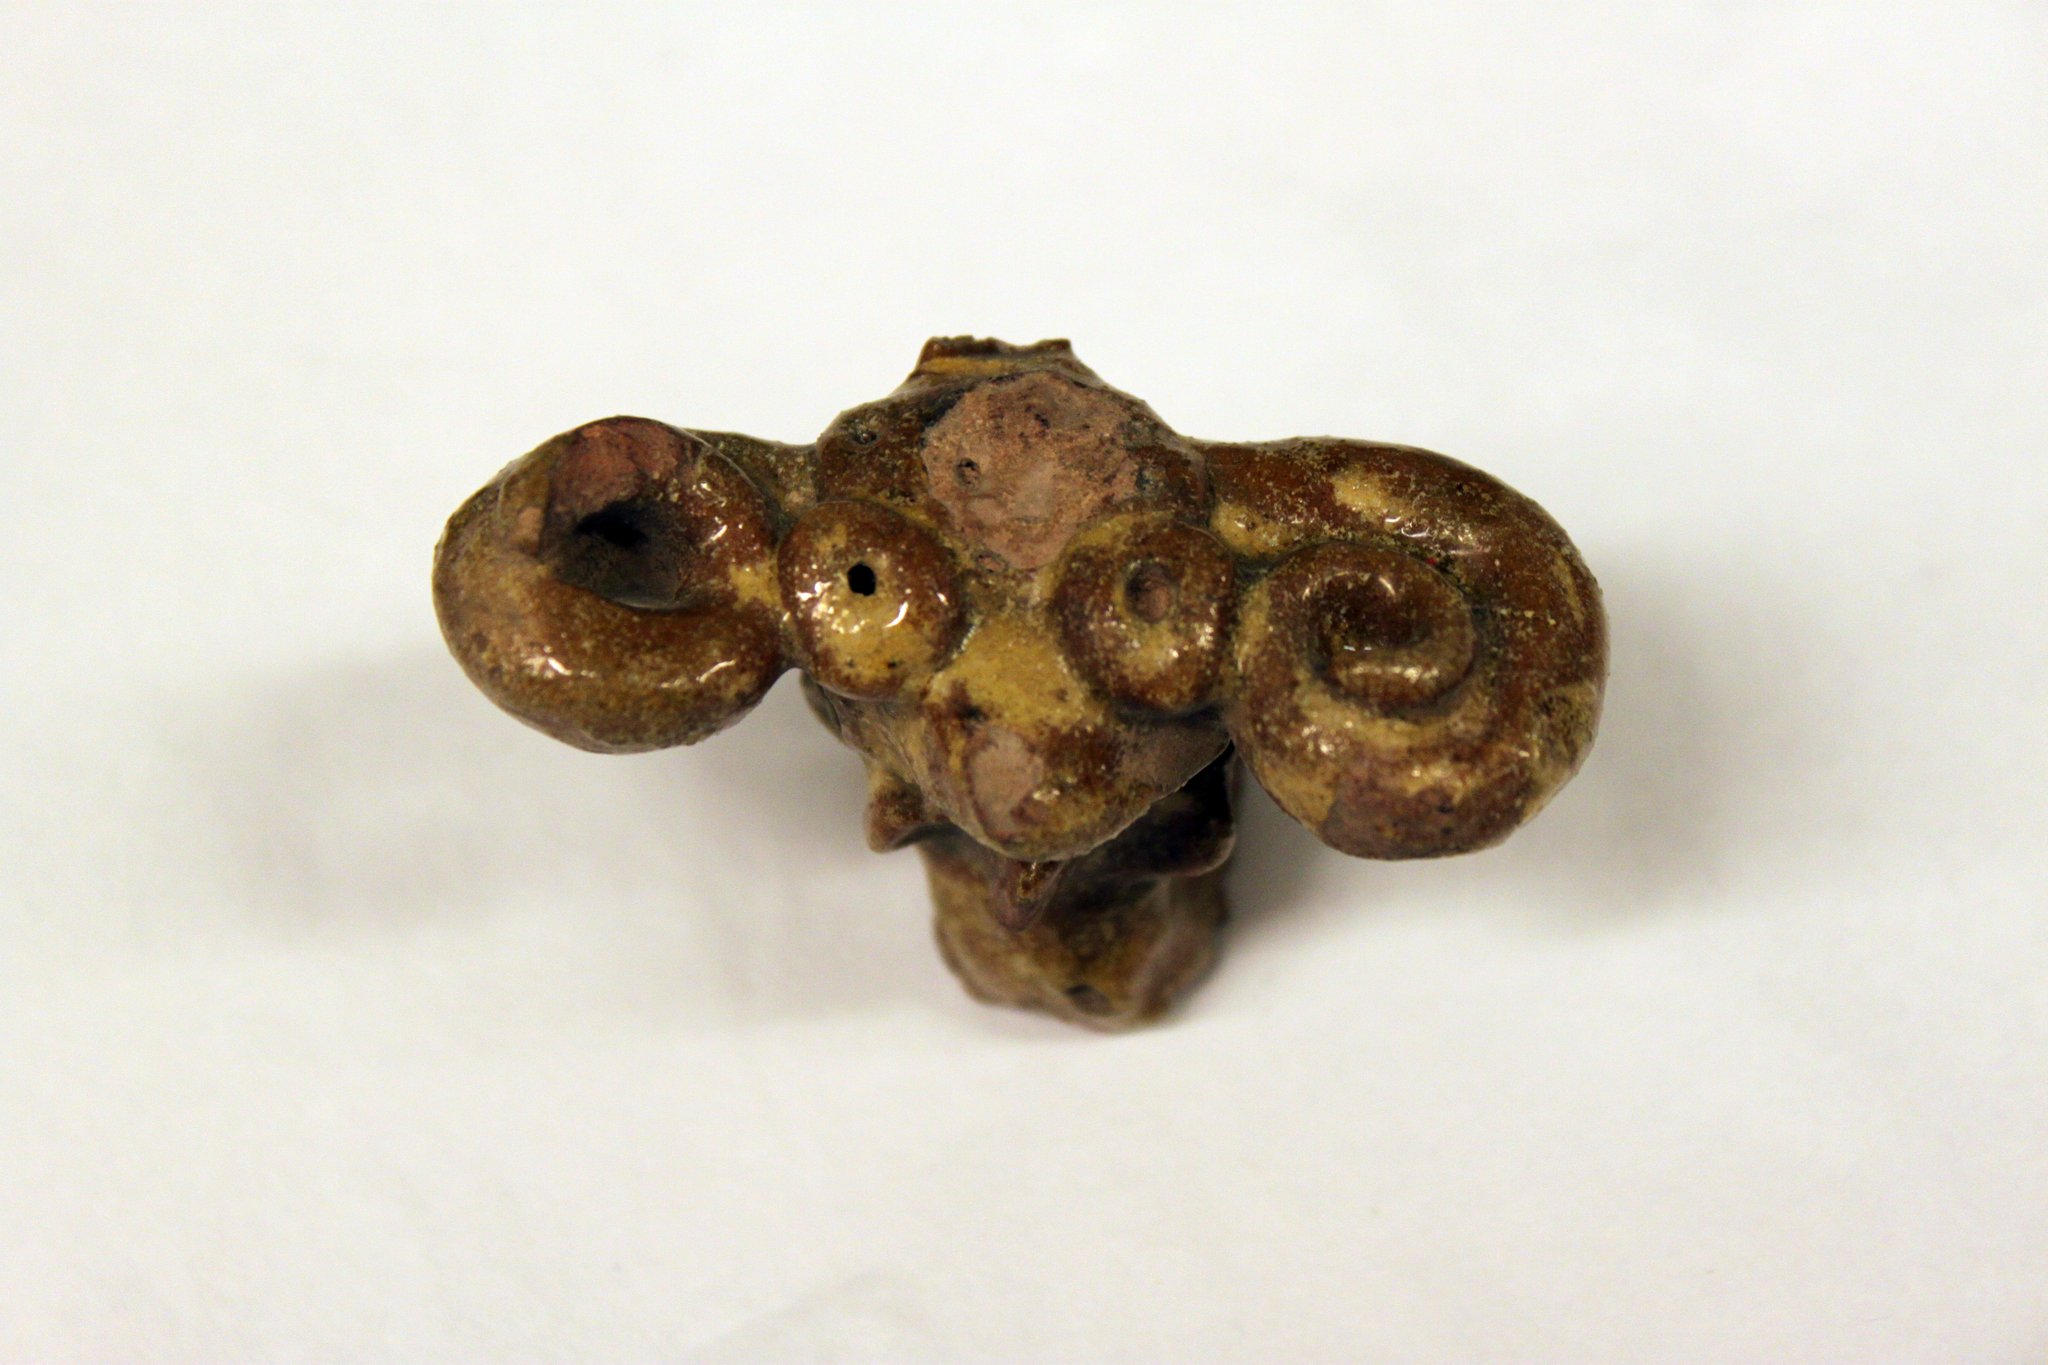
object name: fragment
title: Ceramic Fragment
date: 801-1000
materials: earthenware, glaze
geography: iran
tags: animals